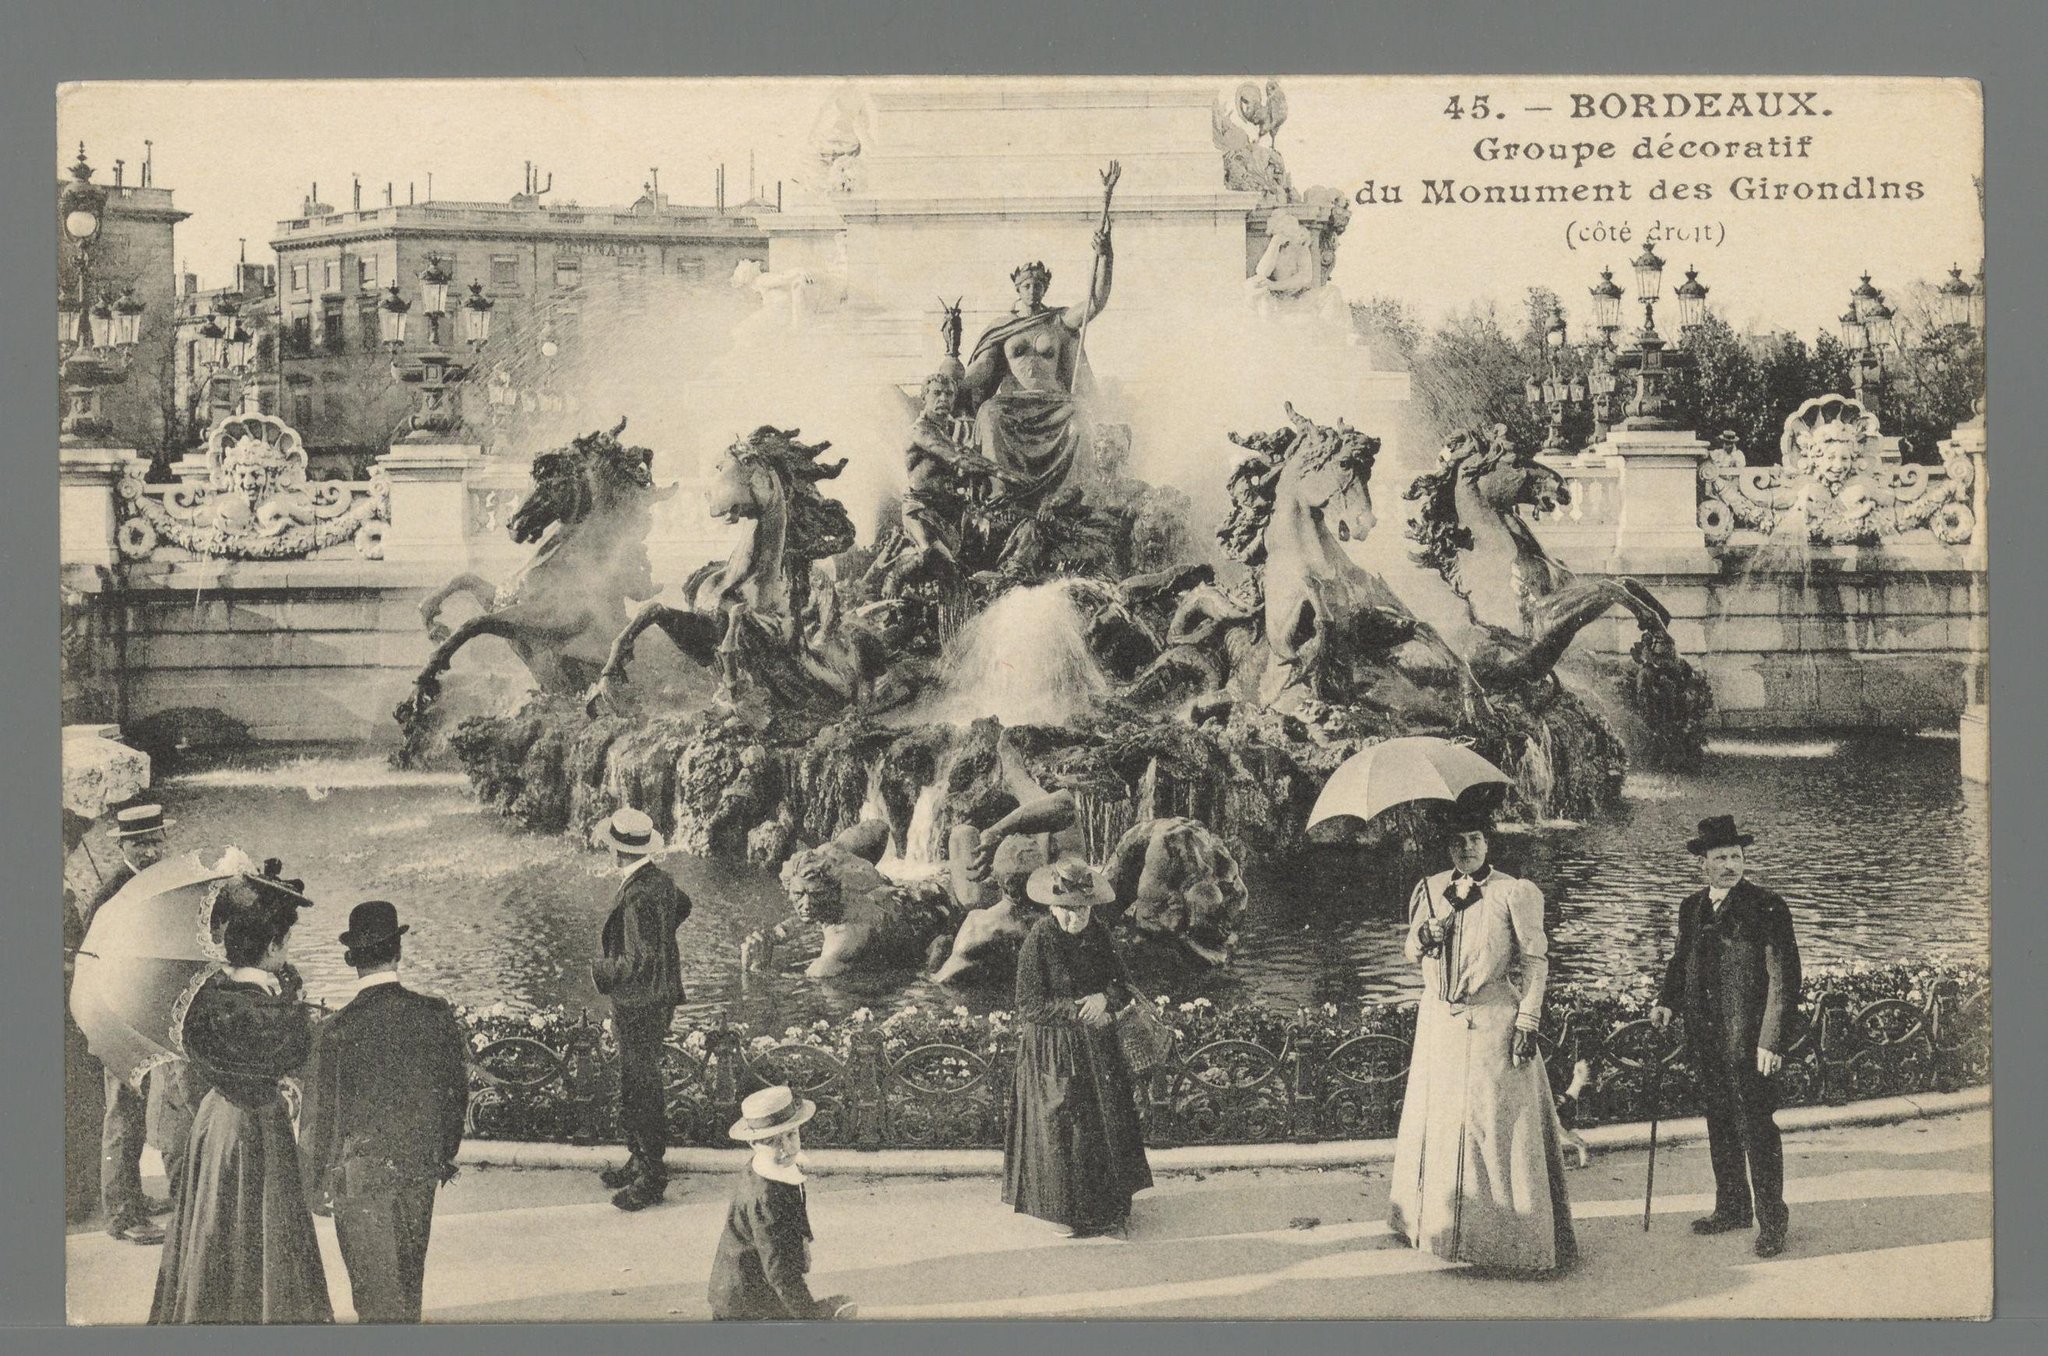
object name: photomechanical print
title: Bordeaux. Groupe décoratif du Monument des Girondins (côté droit)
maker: Anonymous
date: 1904-1906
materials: cardboard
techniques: photograph, writing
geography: bordeaux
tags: sculpture, ornamental fountain (+ city(-scape) with figures, staffage)